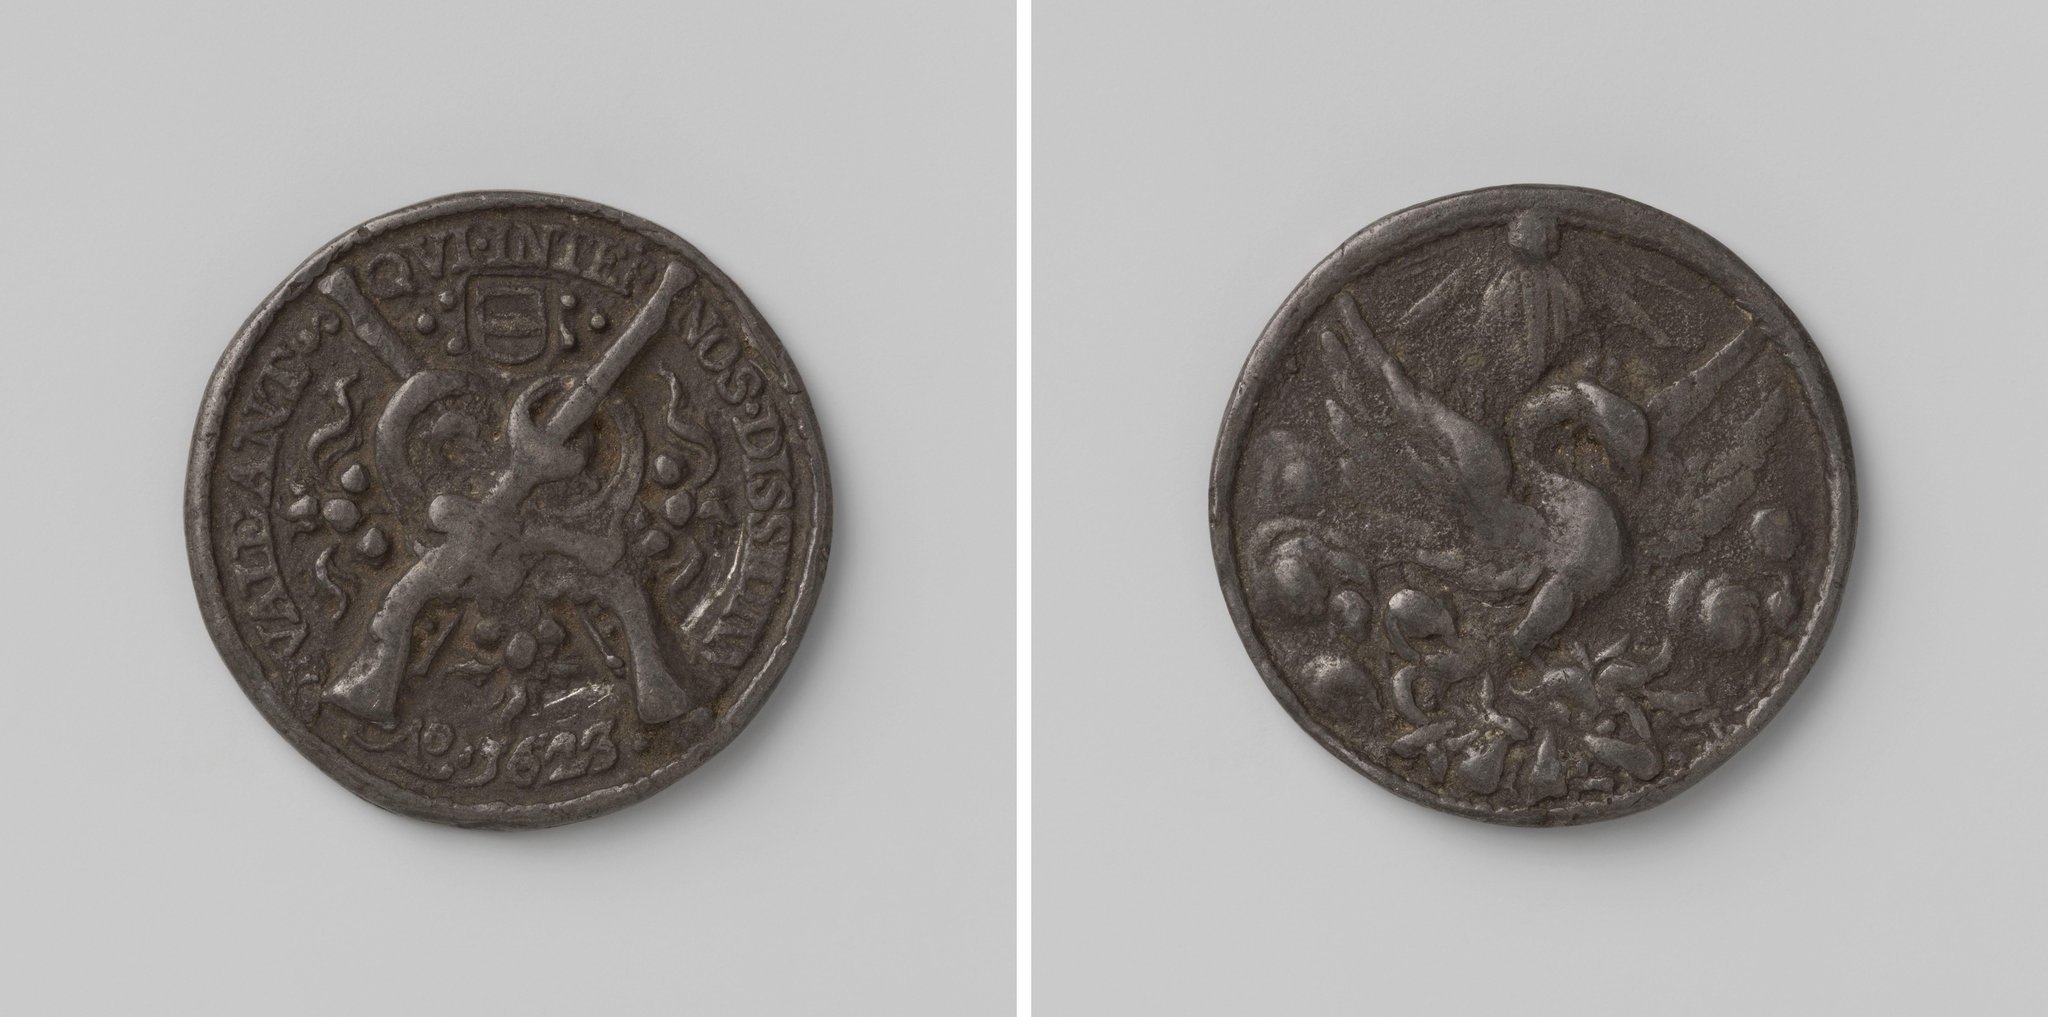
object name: marksman medal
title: Hof van de Edele Busse te Veere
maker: johannes looff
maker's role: die cutter, draughtsman, print maker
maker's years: -1651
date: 1623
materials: tin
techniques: casting, engraving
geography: middelburg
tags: veere